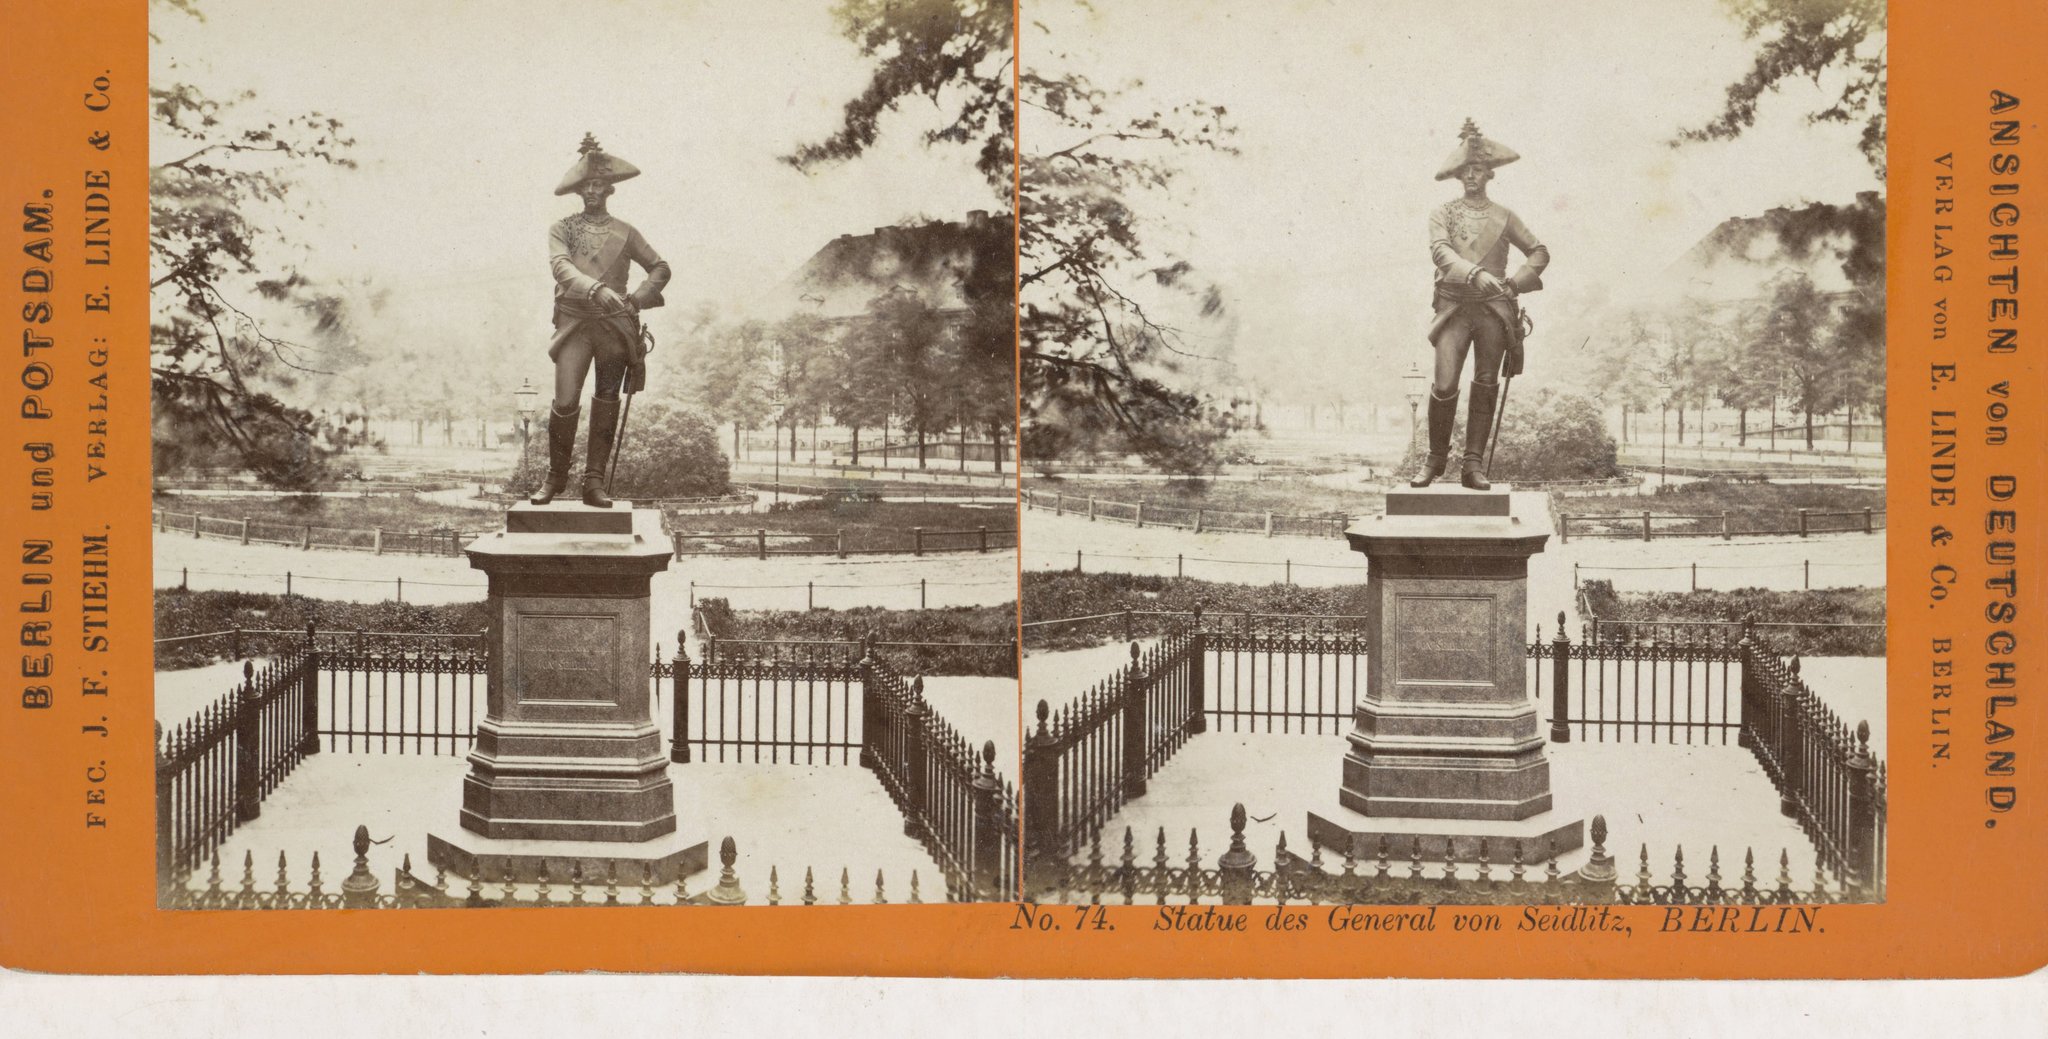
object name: stereograph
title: Ansichten von Deutschland / Berlin und Potsdam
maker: johann friedrich stiehm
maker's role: fotograaf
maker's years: 1826-1902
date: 1868-1870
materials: cardboard, paper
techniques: albumen print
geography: wilhelmplatz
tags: kalkar, monument, statue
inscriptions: number: ‘No. 74.’